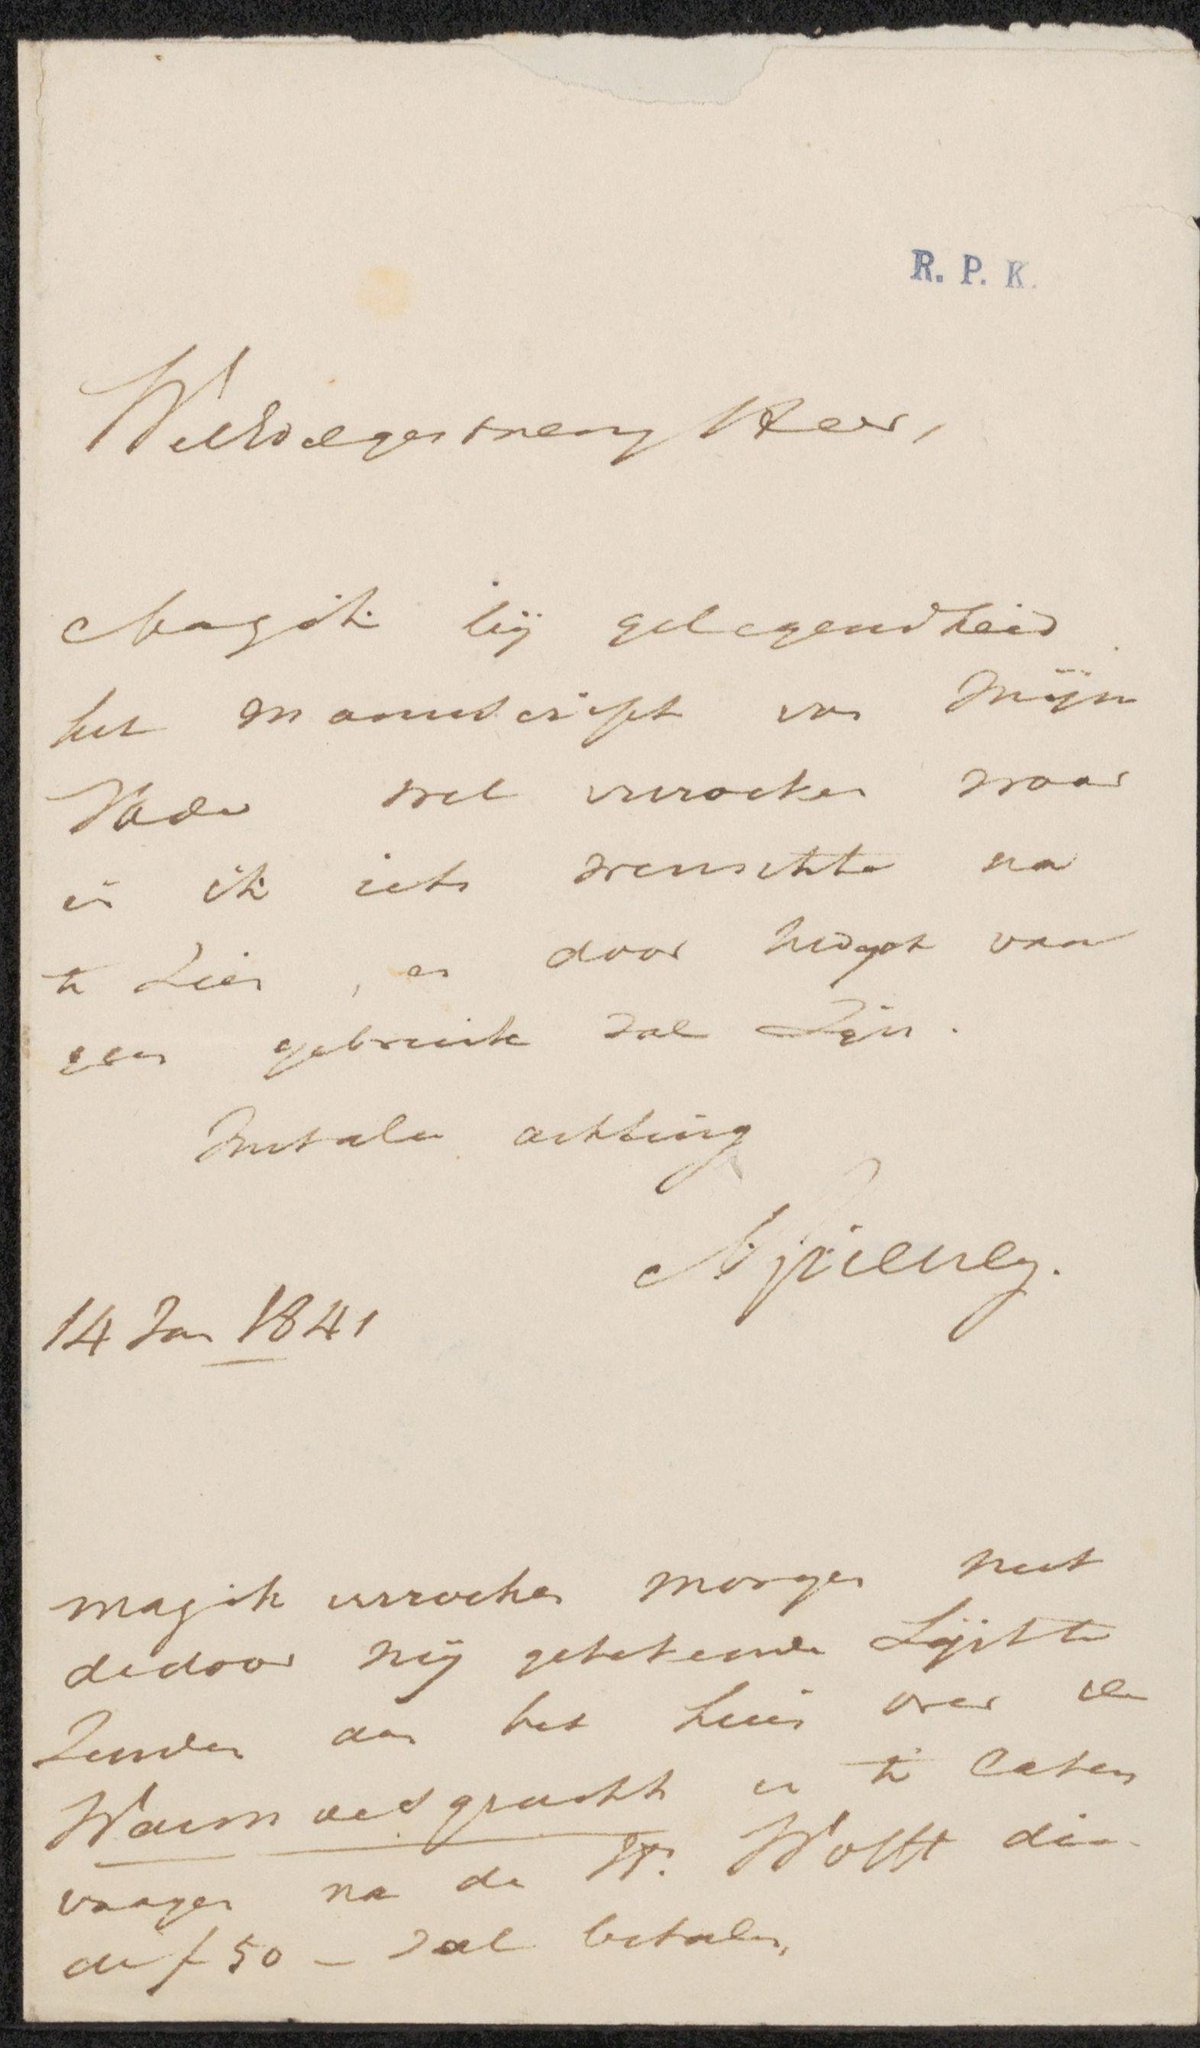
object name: letter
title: Brief aan anoniem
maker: Anonymous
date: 1841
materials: ink, paper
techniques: pen, writing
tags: money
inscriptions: collector's mark: Lugt 2233